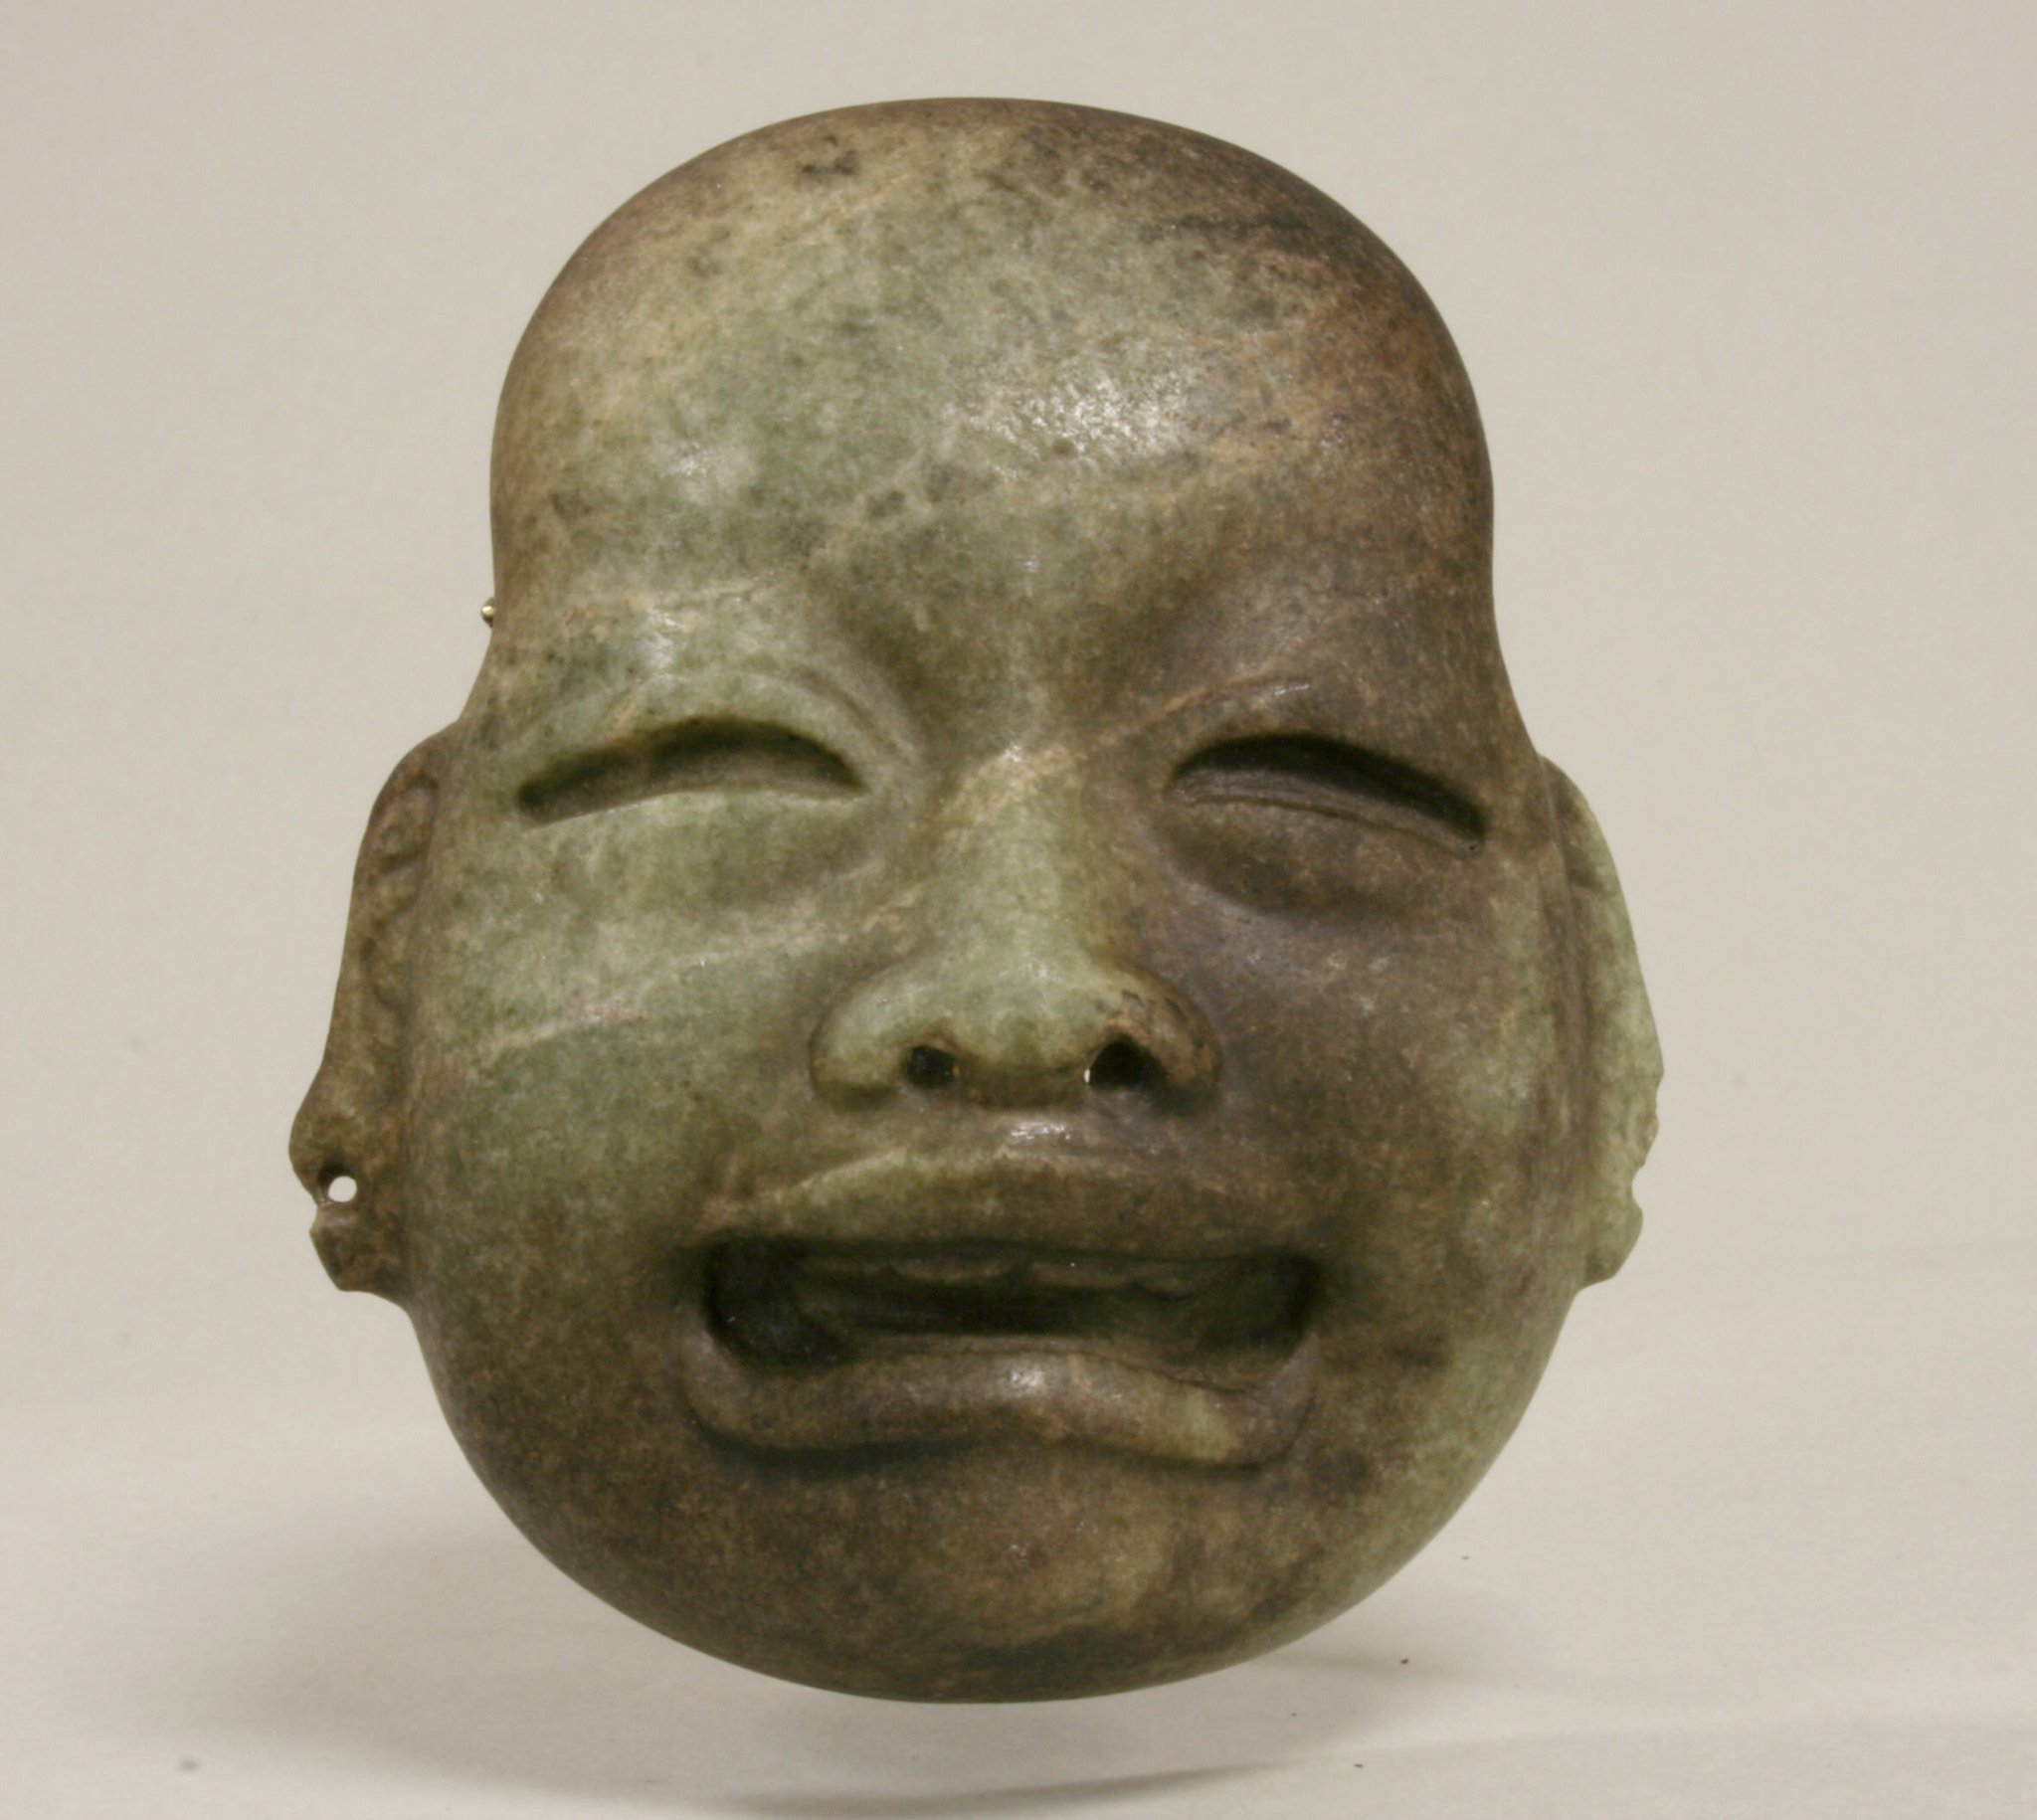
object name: miniature mask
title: Mask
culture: olmec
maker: olmec artist(s)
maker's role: artist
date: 1000-400 BCE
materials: stone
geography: mexico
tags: faces